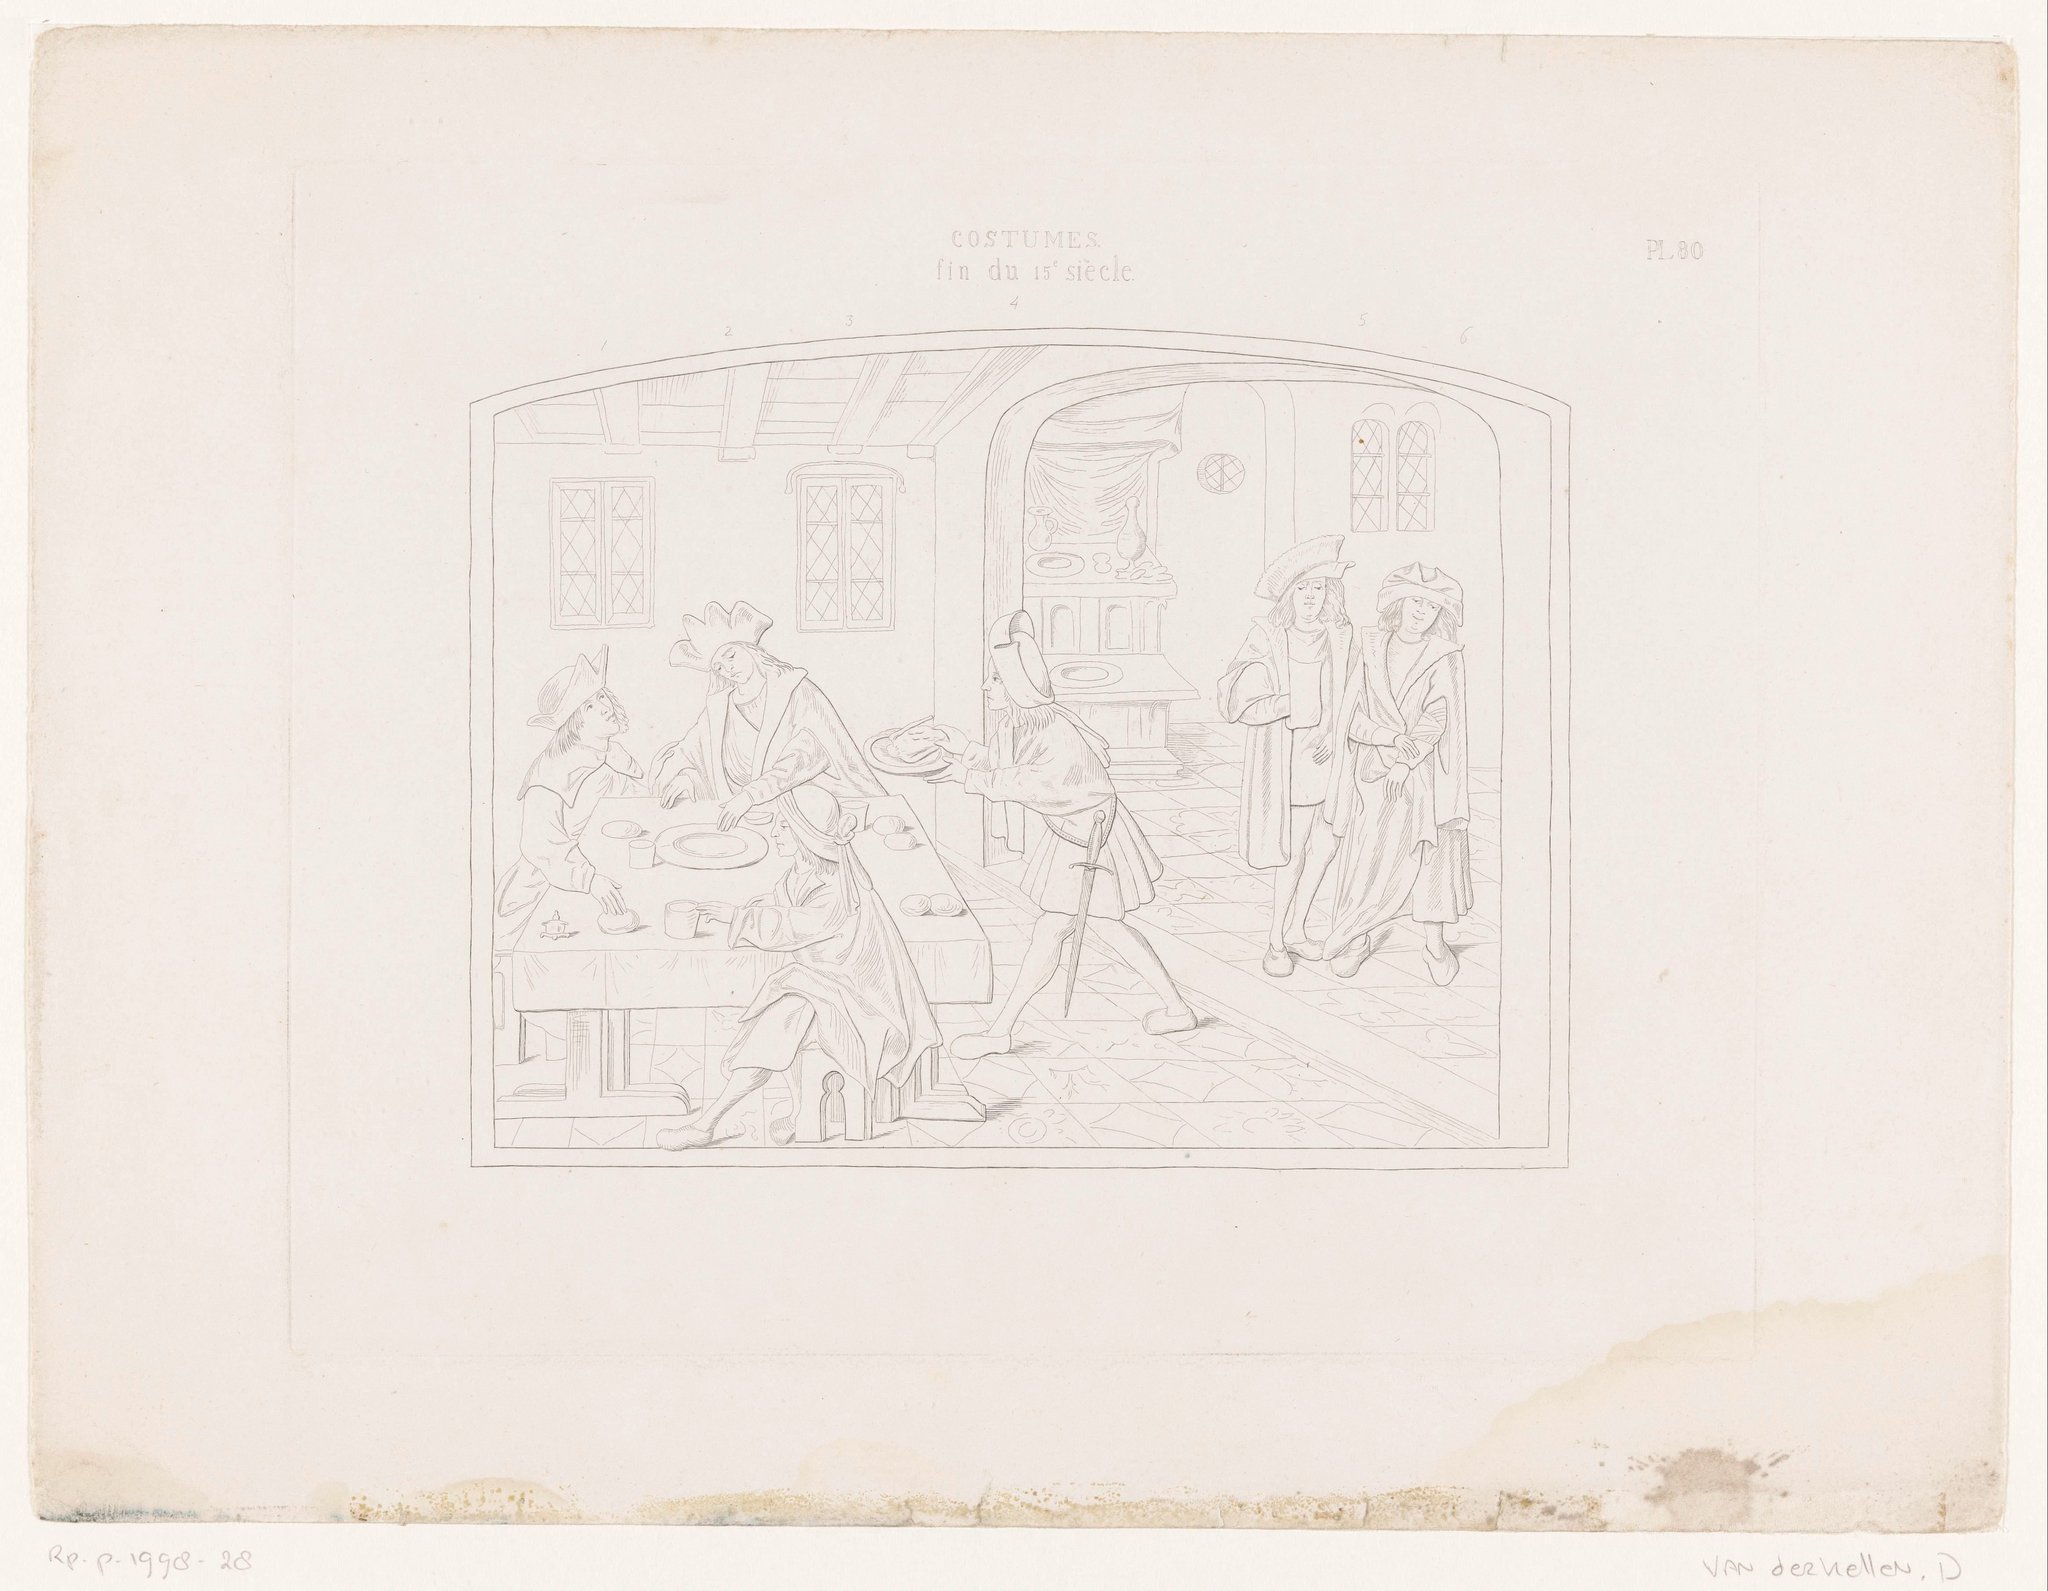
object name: print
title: Costumes fin du 15e siècle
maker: david van der kellen (1804-1879)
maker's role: die cutter, draughtsman, print maker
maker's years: 1804-1879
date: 1865-1878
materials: paper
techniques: etching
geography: netherlands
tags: clothes, costume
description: Laat vijftiende-eeuwse kostuums: Enkele mannen worden aan tafel bediend.